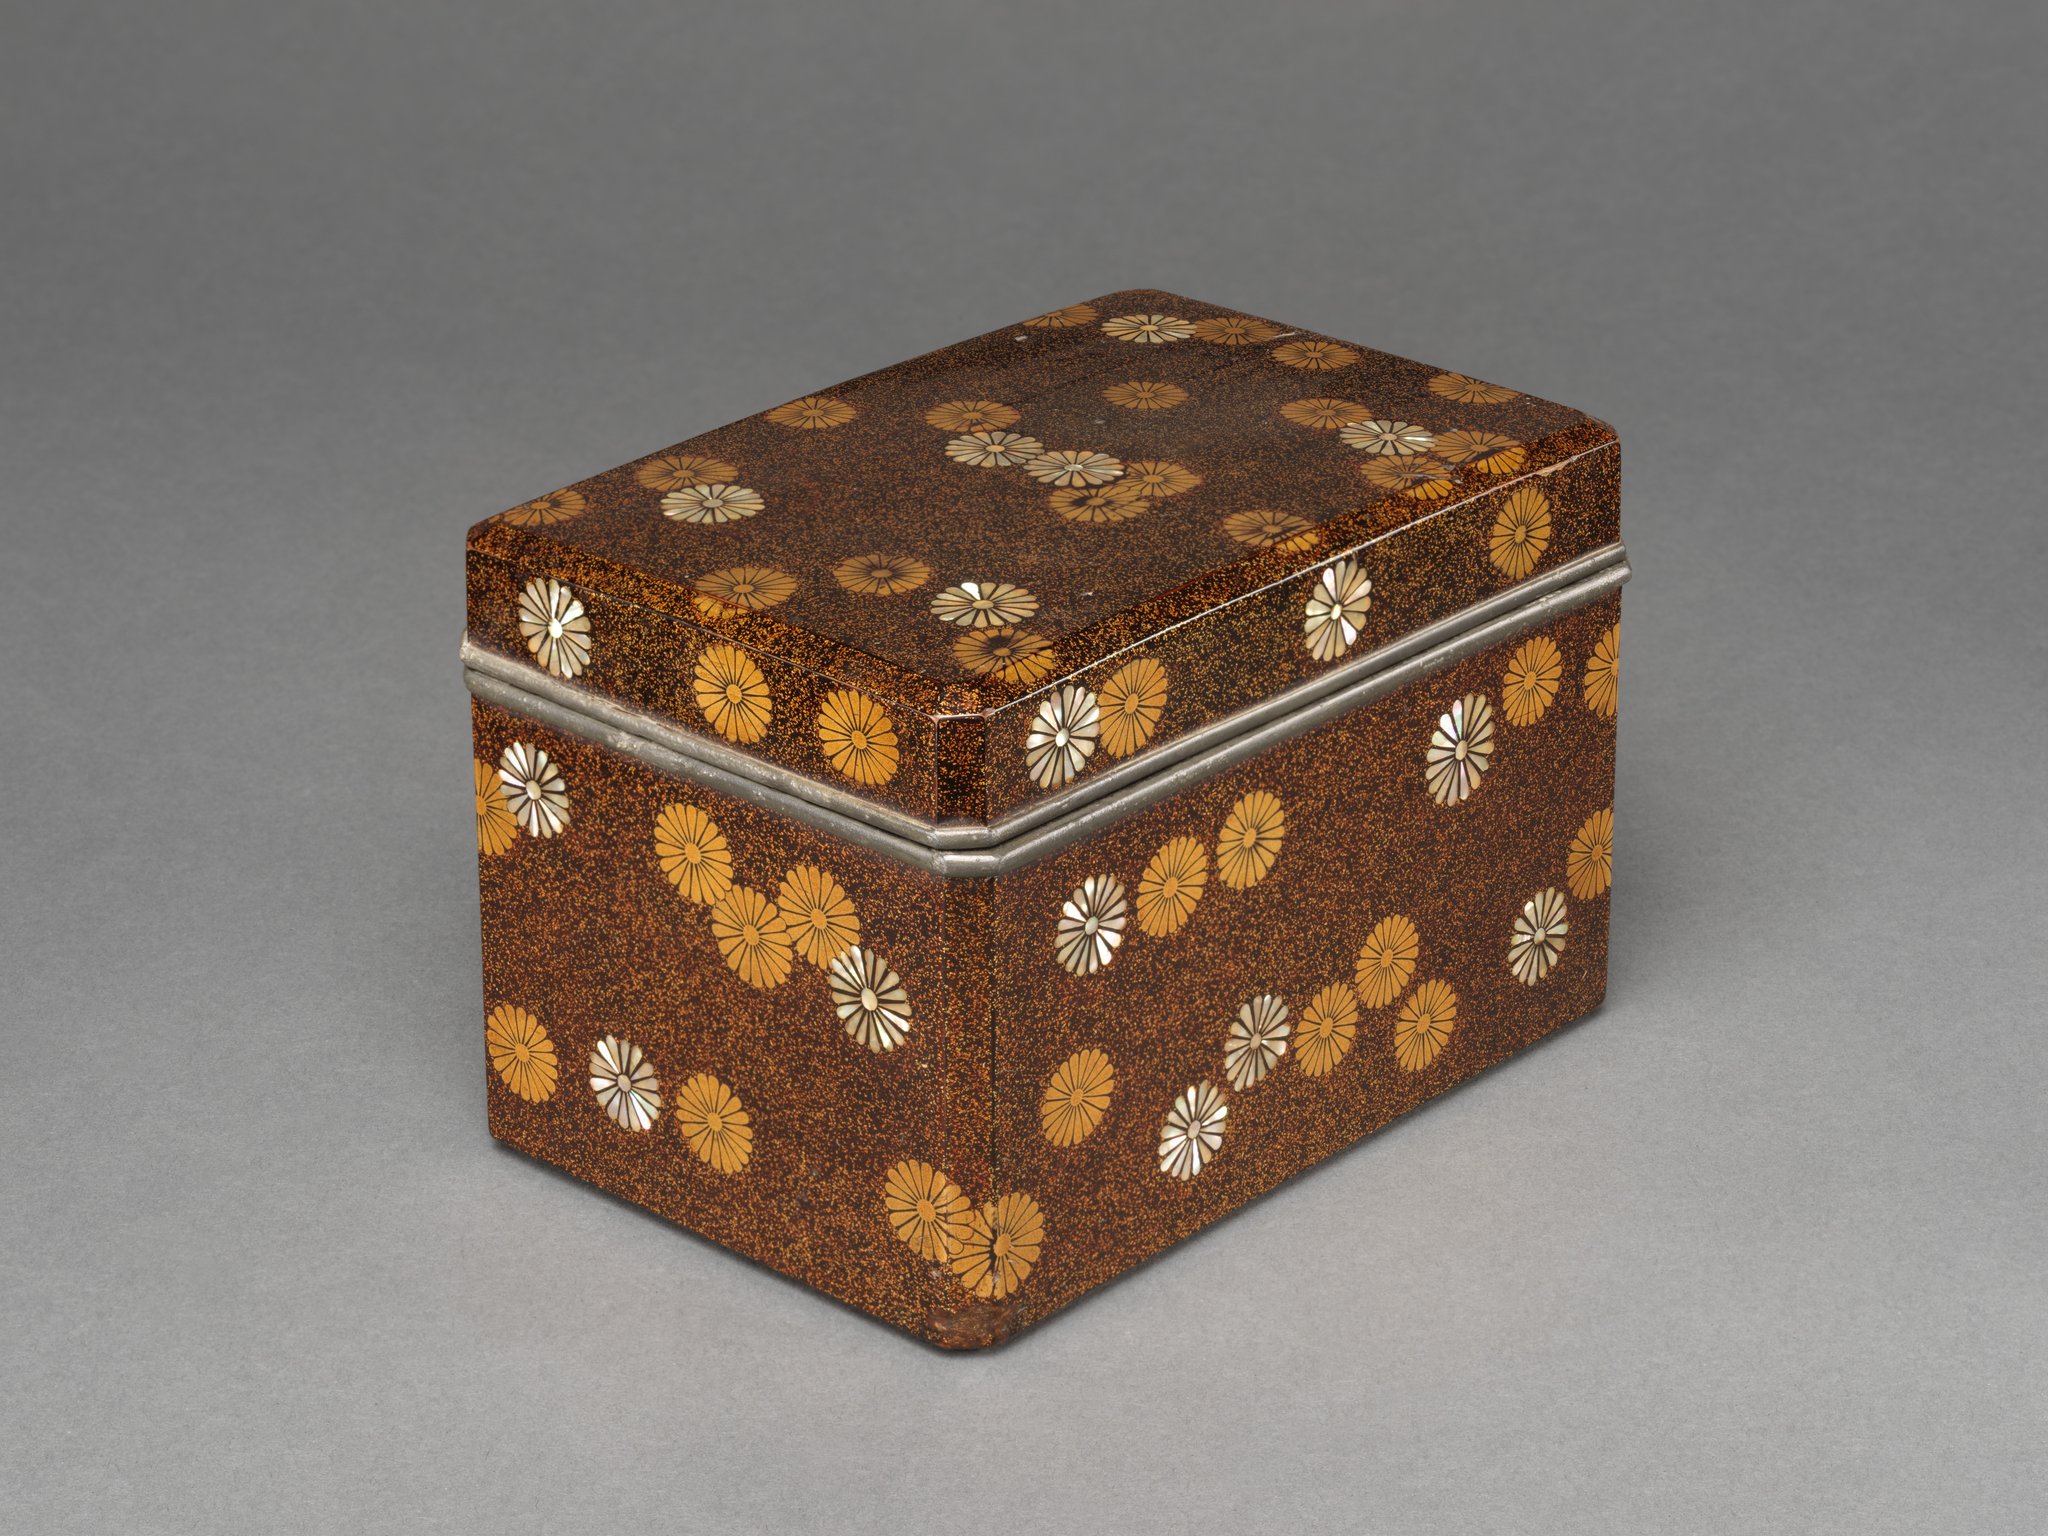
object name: box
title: Tea utensil box (chabako)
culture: japanese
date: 1601-1700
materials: mother of pearl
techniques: maki